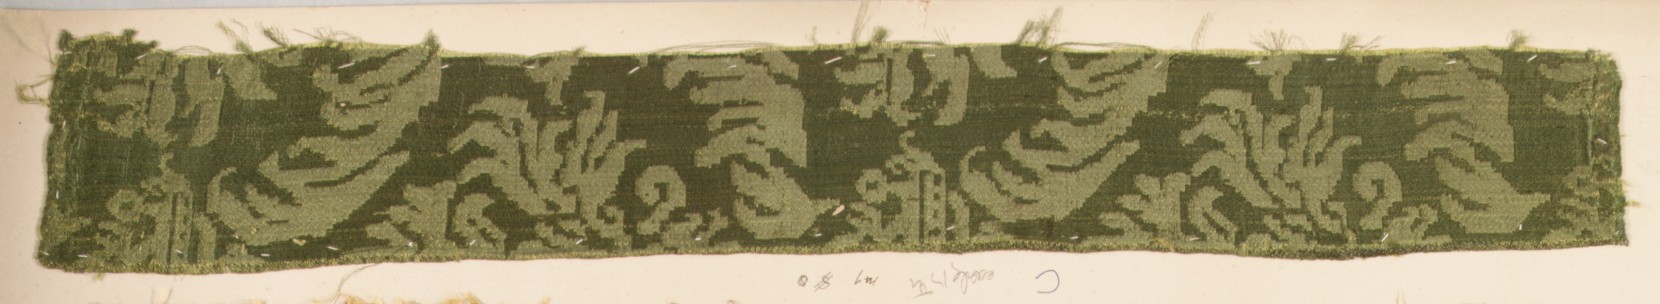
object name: fragment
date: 1601-1633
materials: silk